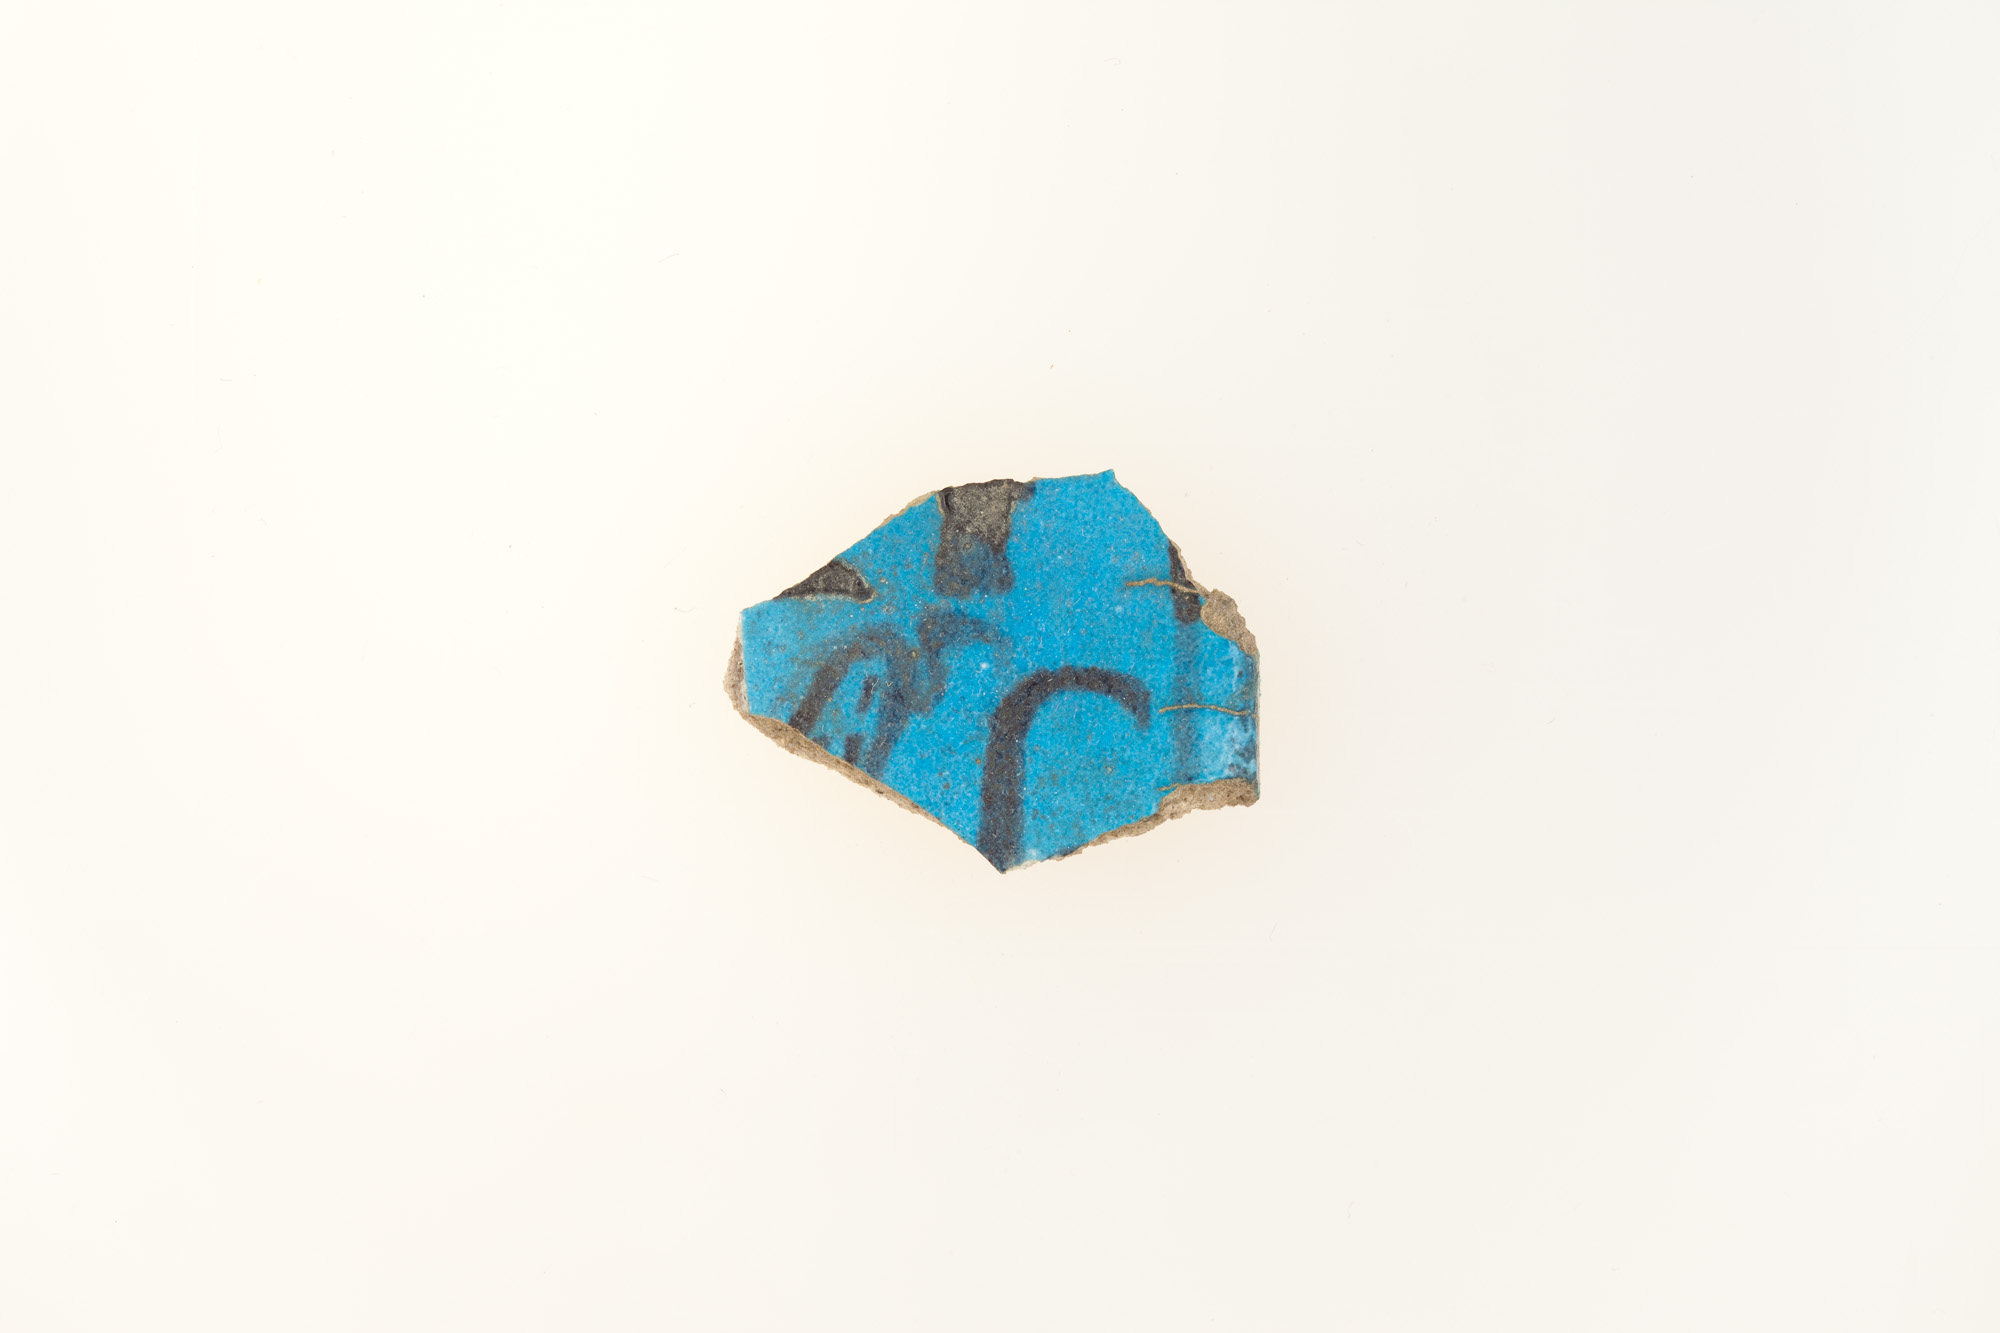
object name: menat fragment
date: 1479-1458 BCE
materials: faience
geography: egypt